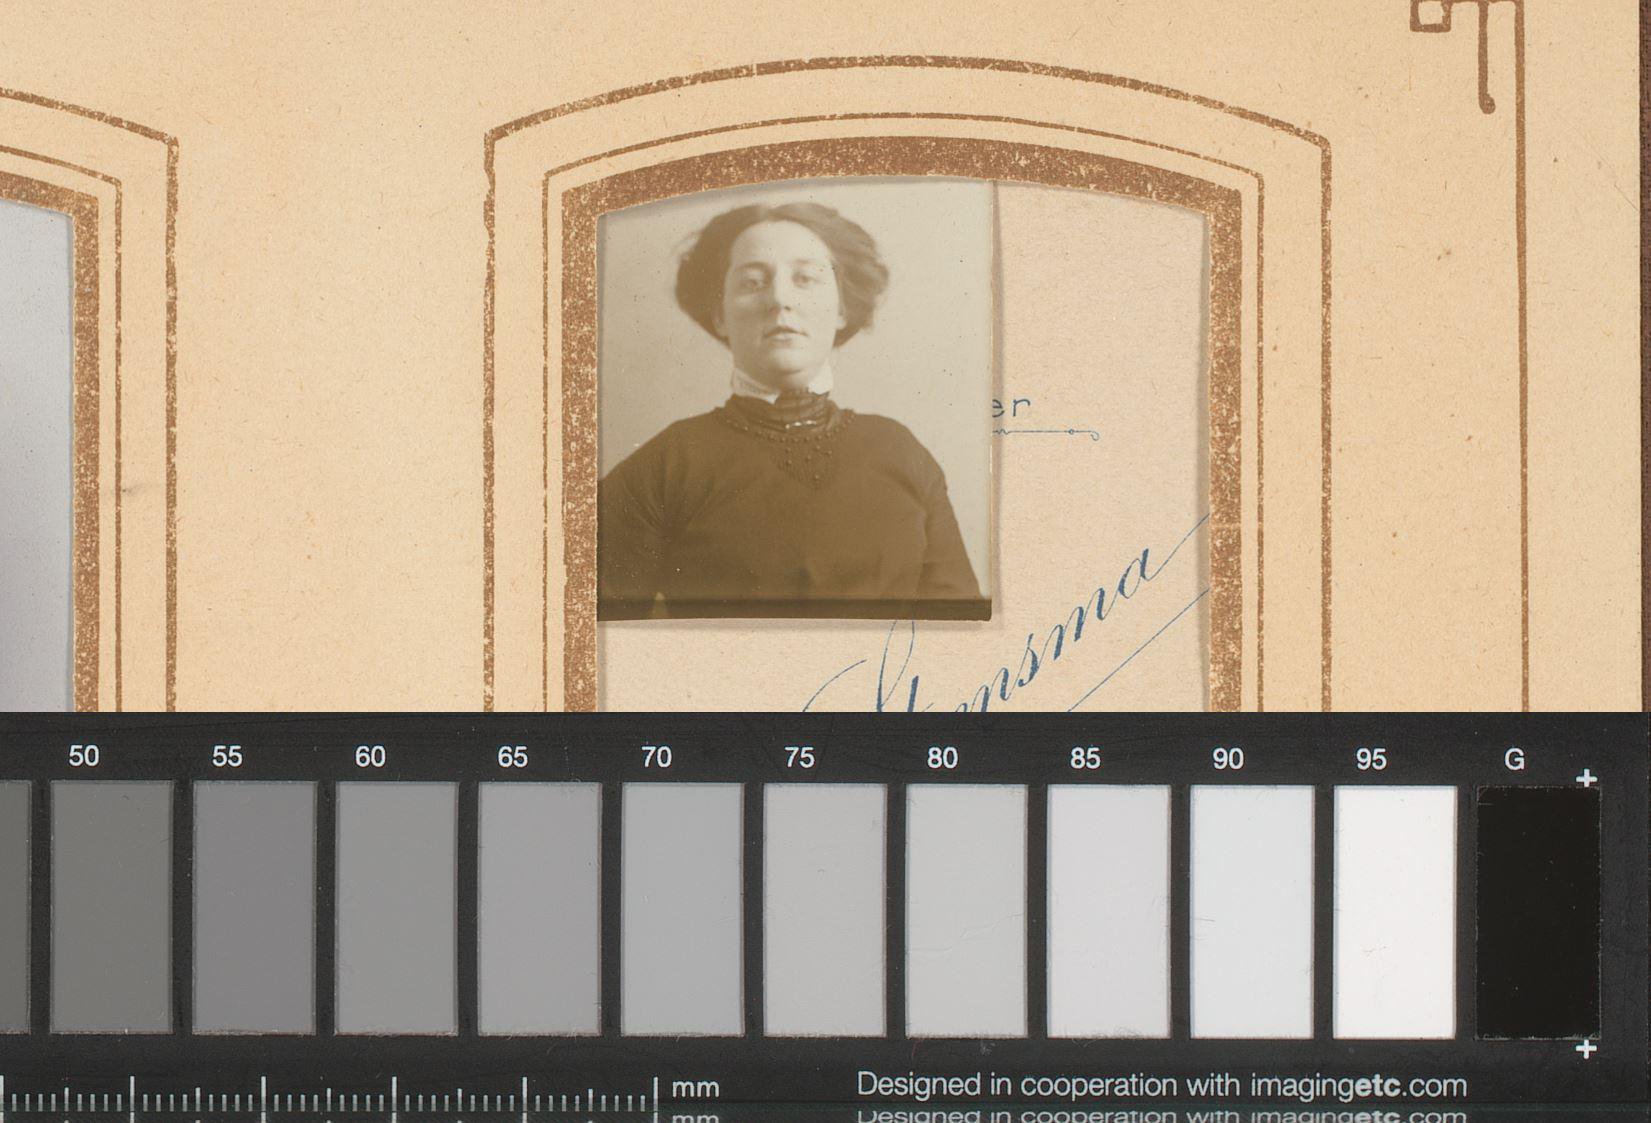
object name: album leaf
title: Portret van een vrouw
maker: Anonymous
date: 1880-1920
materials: photographic support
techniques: gelatin silver print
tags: historical persons - bb - woman